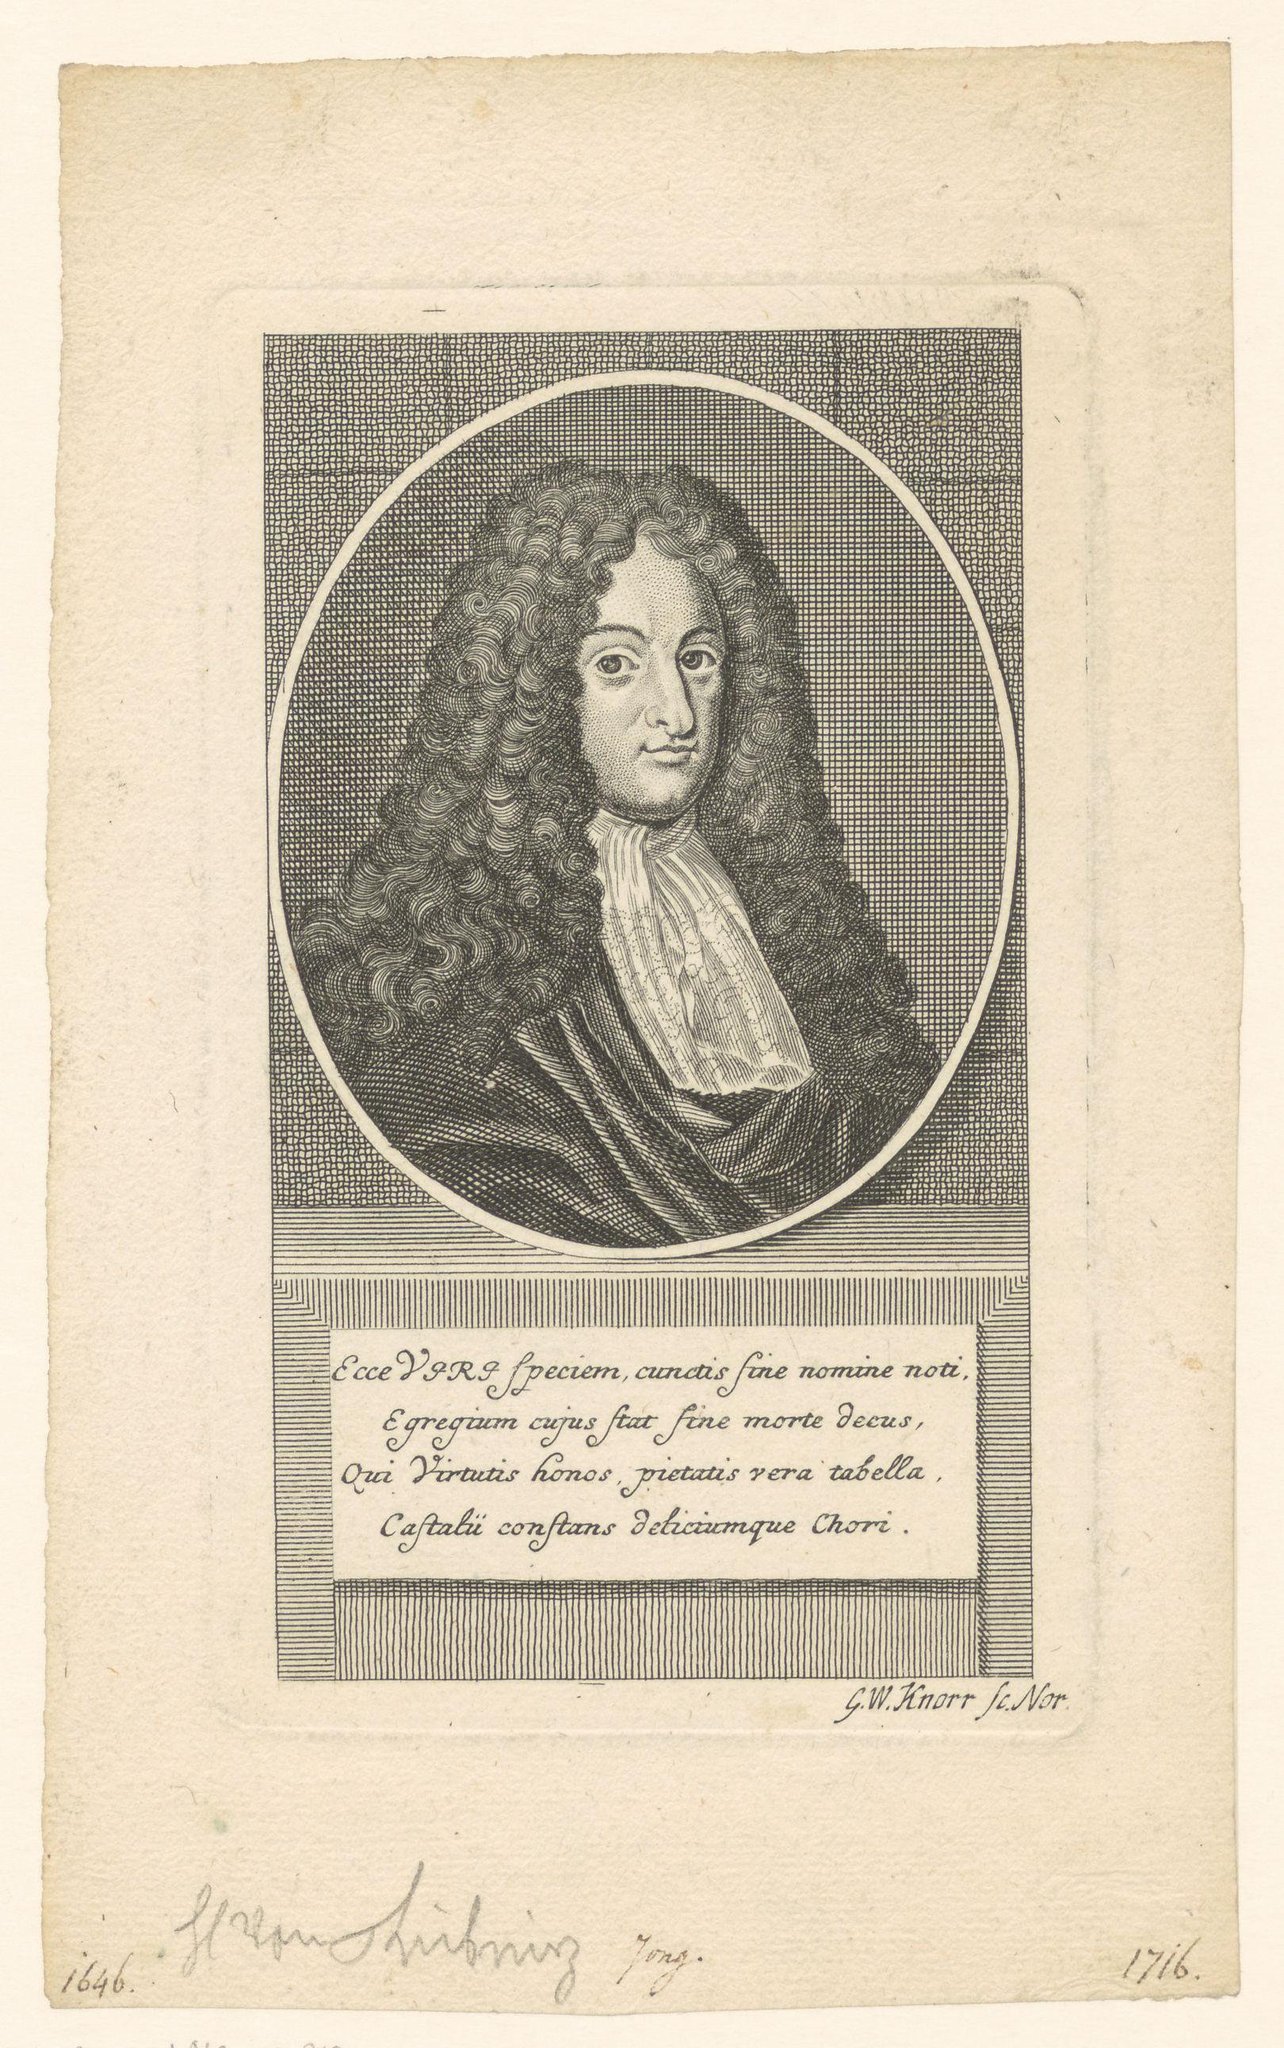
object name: print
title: Portret van Hans Thubing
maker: georg wolfgang knorr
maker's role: print maker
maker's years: 1705-1761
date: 1715-1761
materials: paper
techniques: engraving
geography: nuremberg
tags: historical persons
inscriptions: collector's mark: Lugt 2228